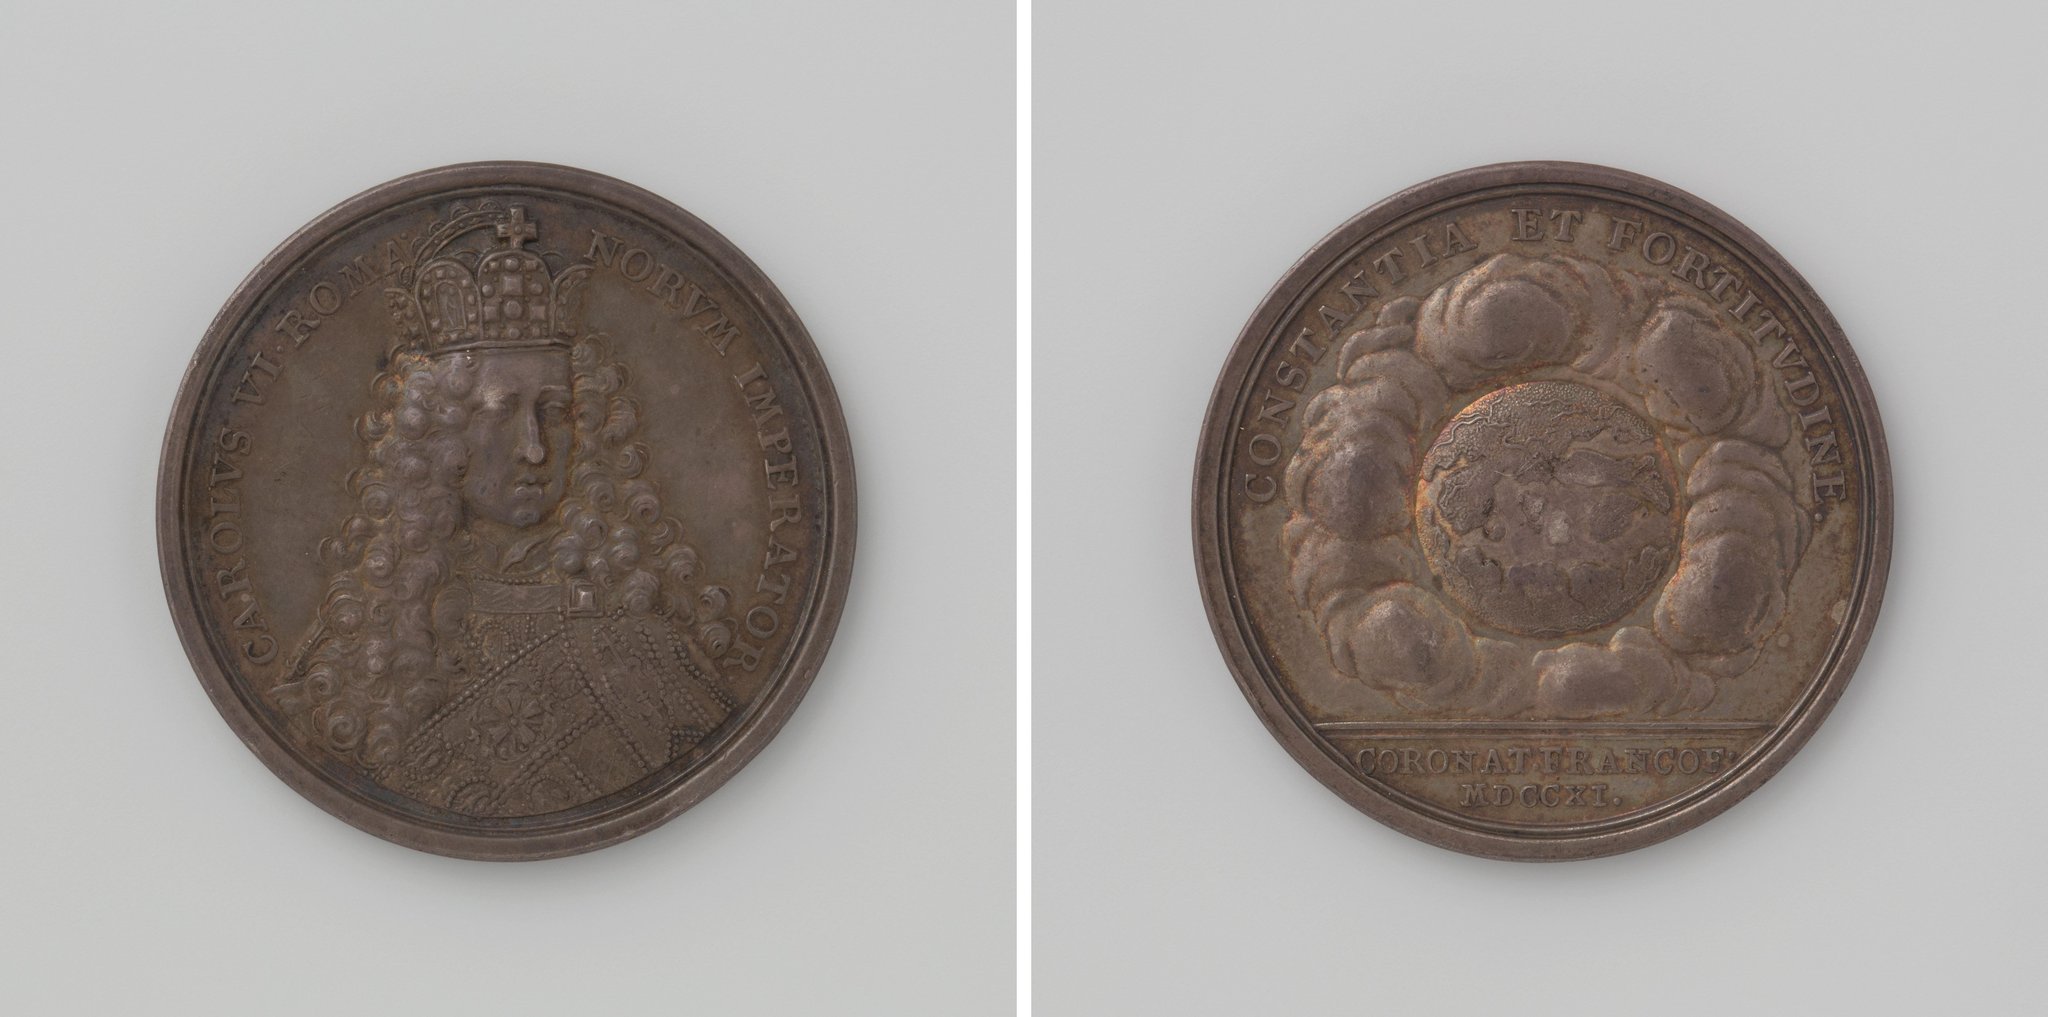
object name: history medal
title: Karel VI tot Duits keizer gekroond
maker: Anonymous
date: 1711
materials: silver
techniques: striking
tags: charles vi (holy roman emperor)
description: Zilveren penning. Voorzijde: borststuk man met keizerskroon in statiegewaad binnen omschrift. Keerzijde: wereldbol binnen ring van wolken en omschrift; afsnede : opschrift